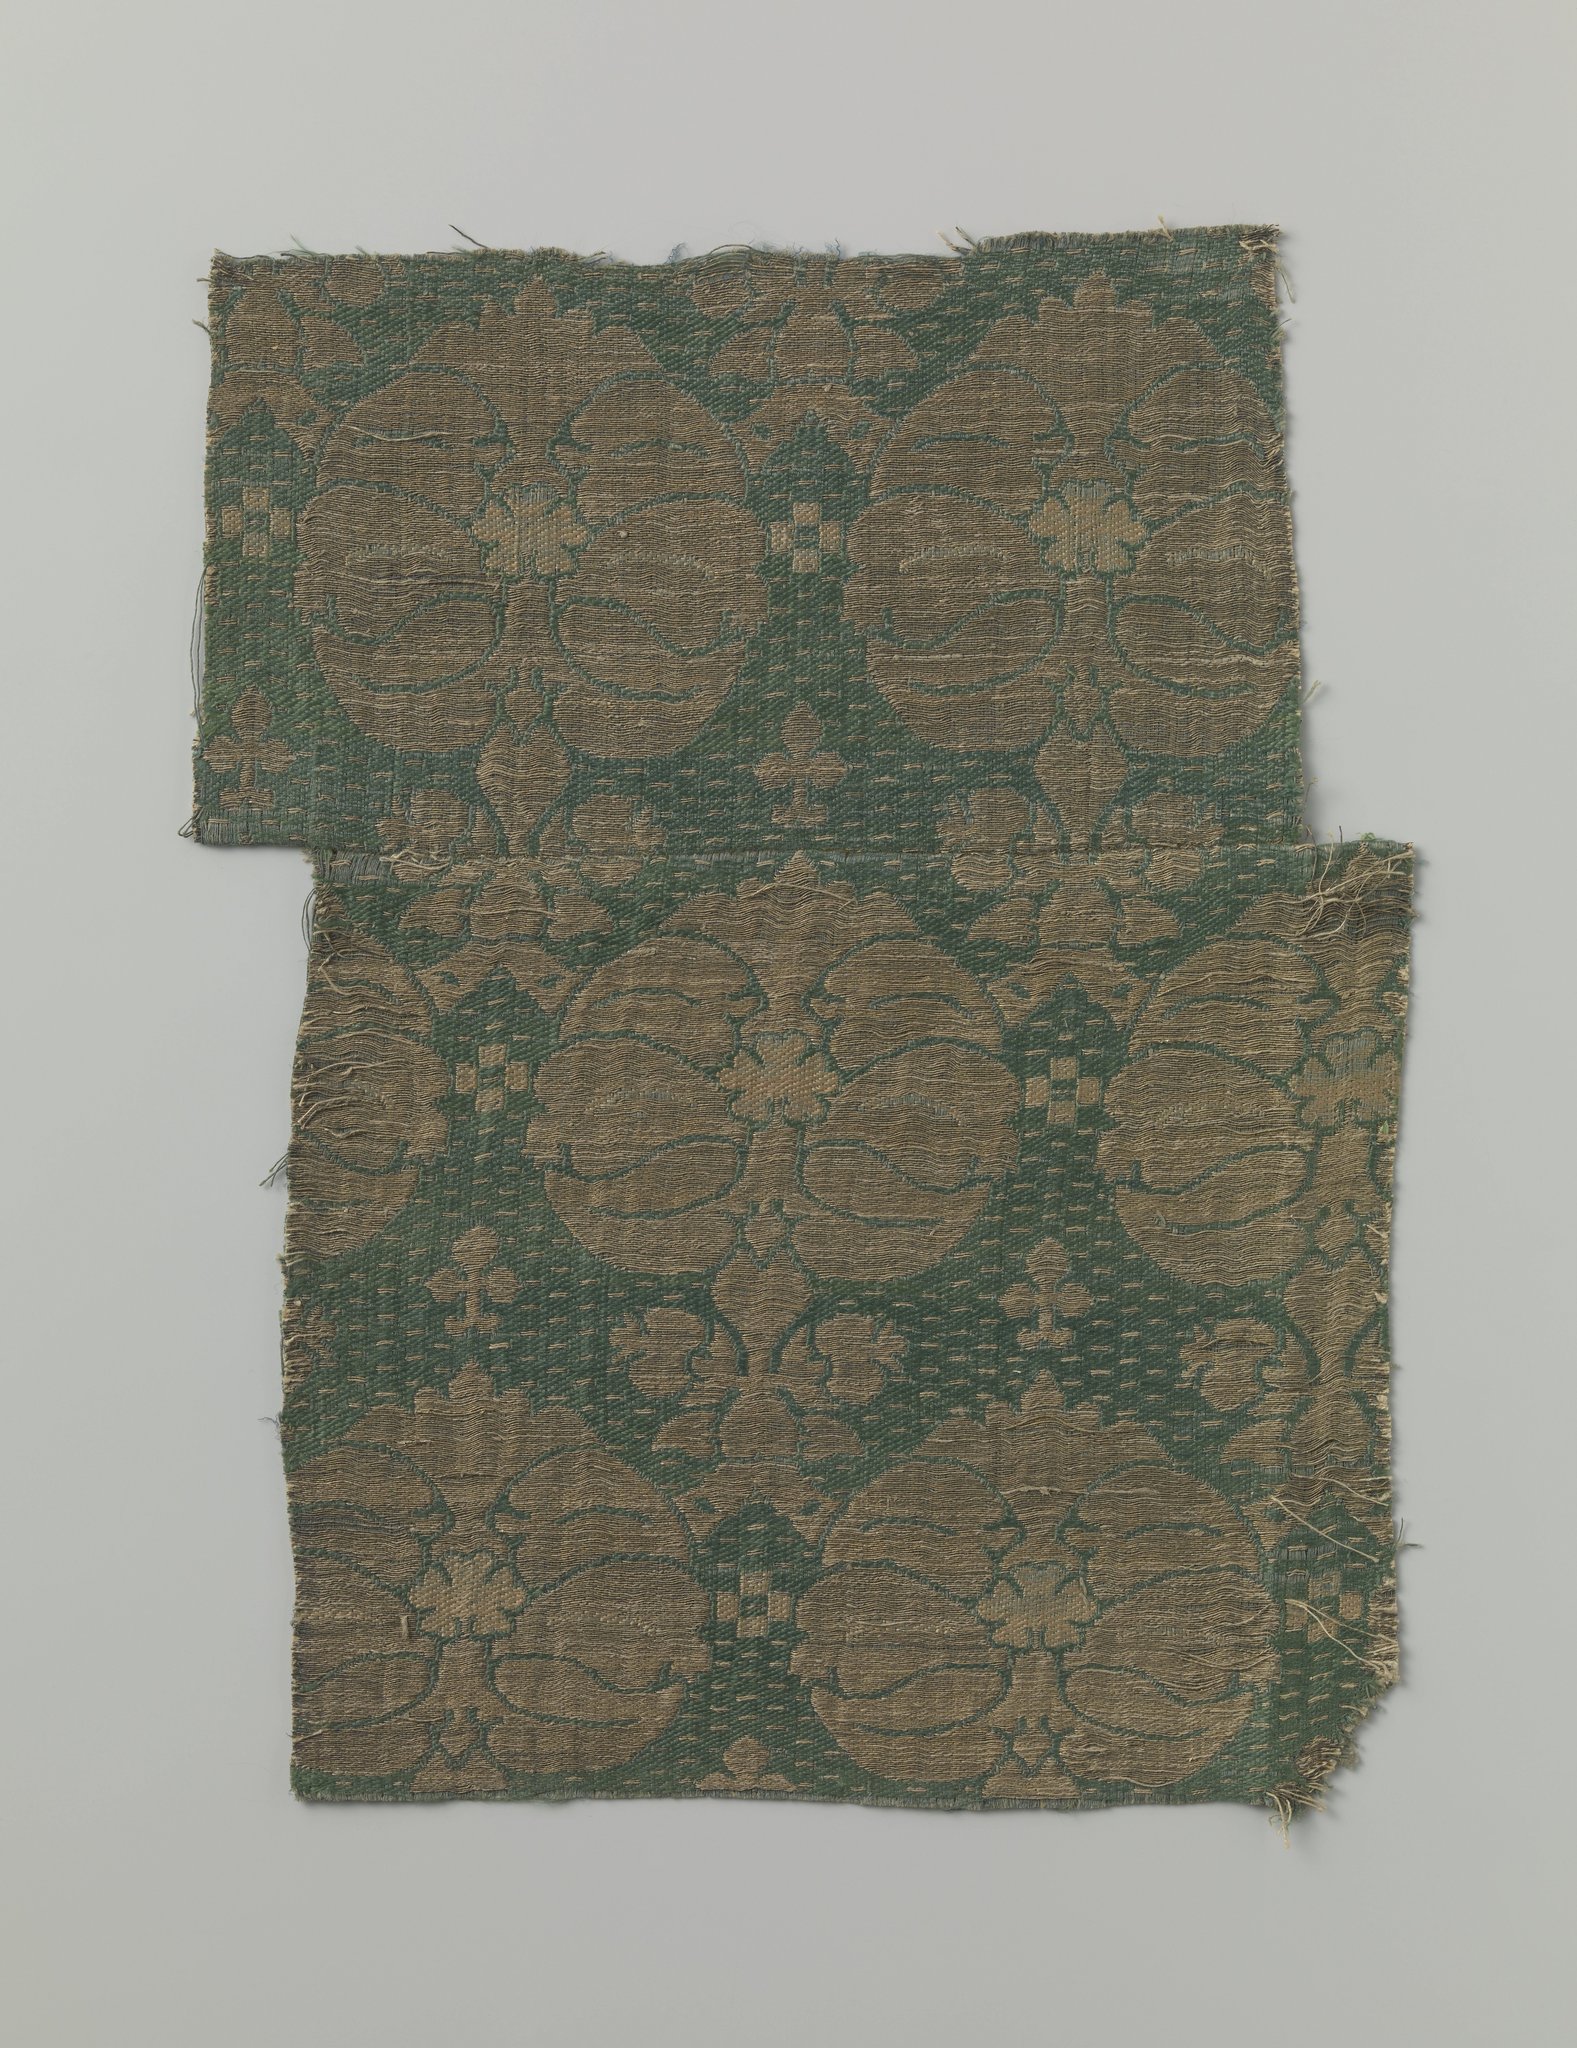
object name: silk textile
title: Fragment groen zijdeweefsel met patroon in gouddraad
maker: Anonymous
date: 1400-1499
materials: gold thread, linen, silk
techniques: weave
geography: germany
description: Fragment groene zijde met patroon in goud van grote hartvormige bladfiguren waartussen Franse lelies. Twee aan elkaar gezette delen.